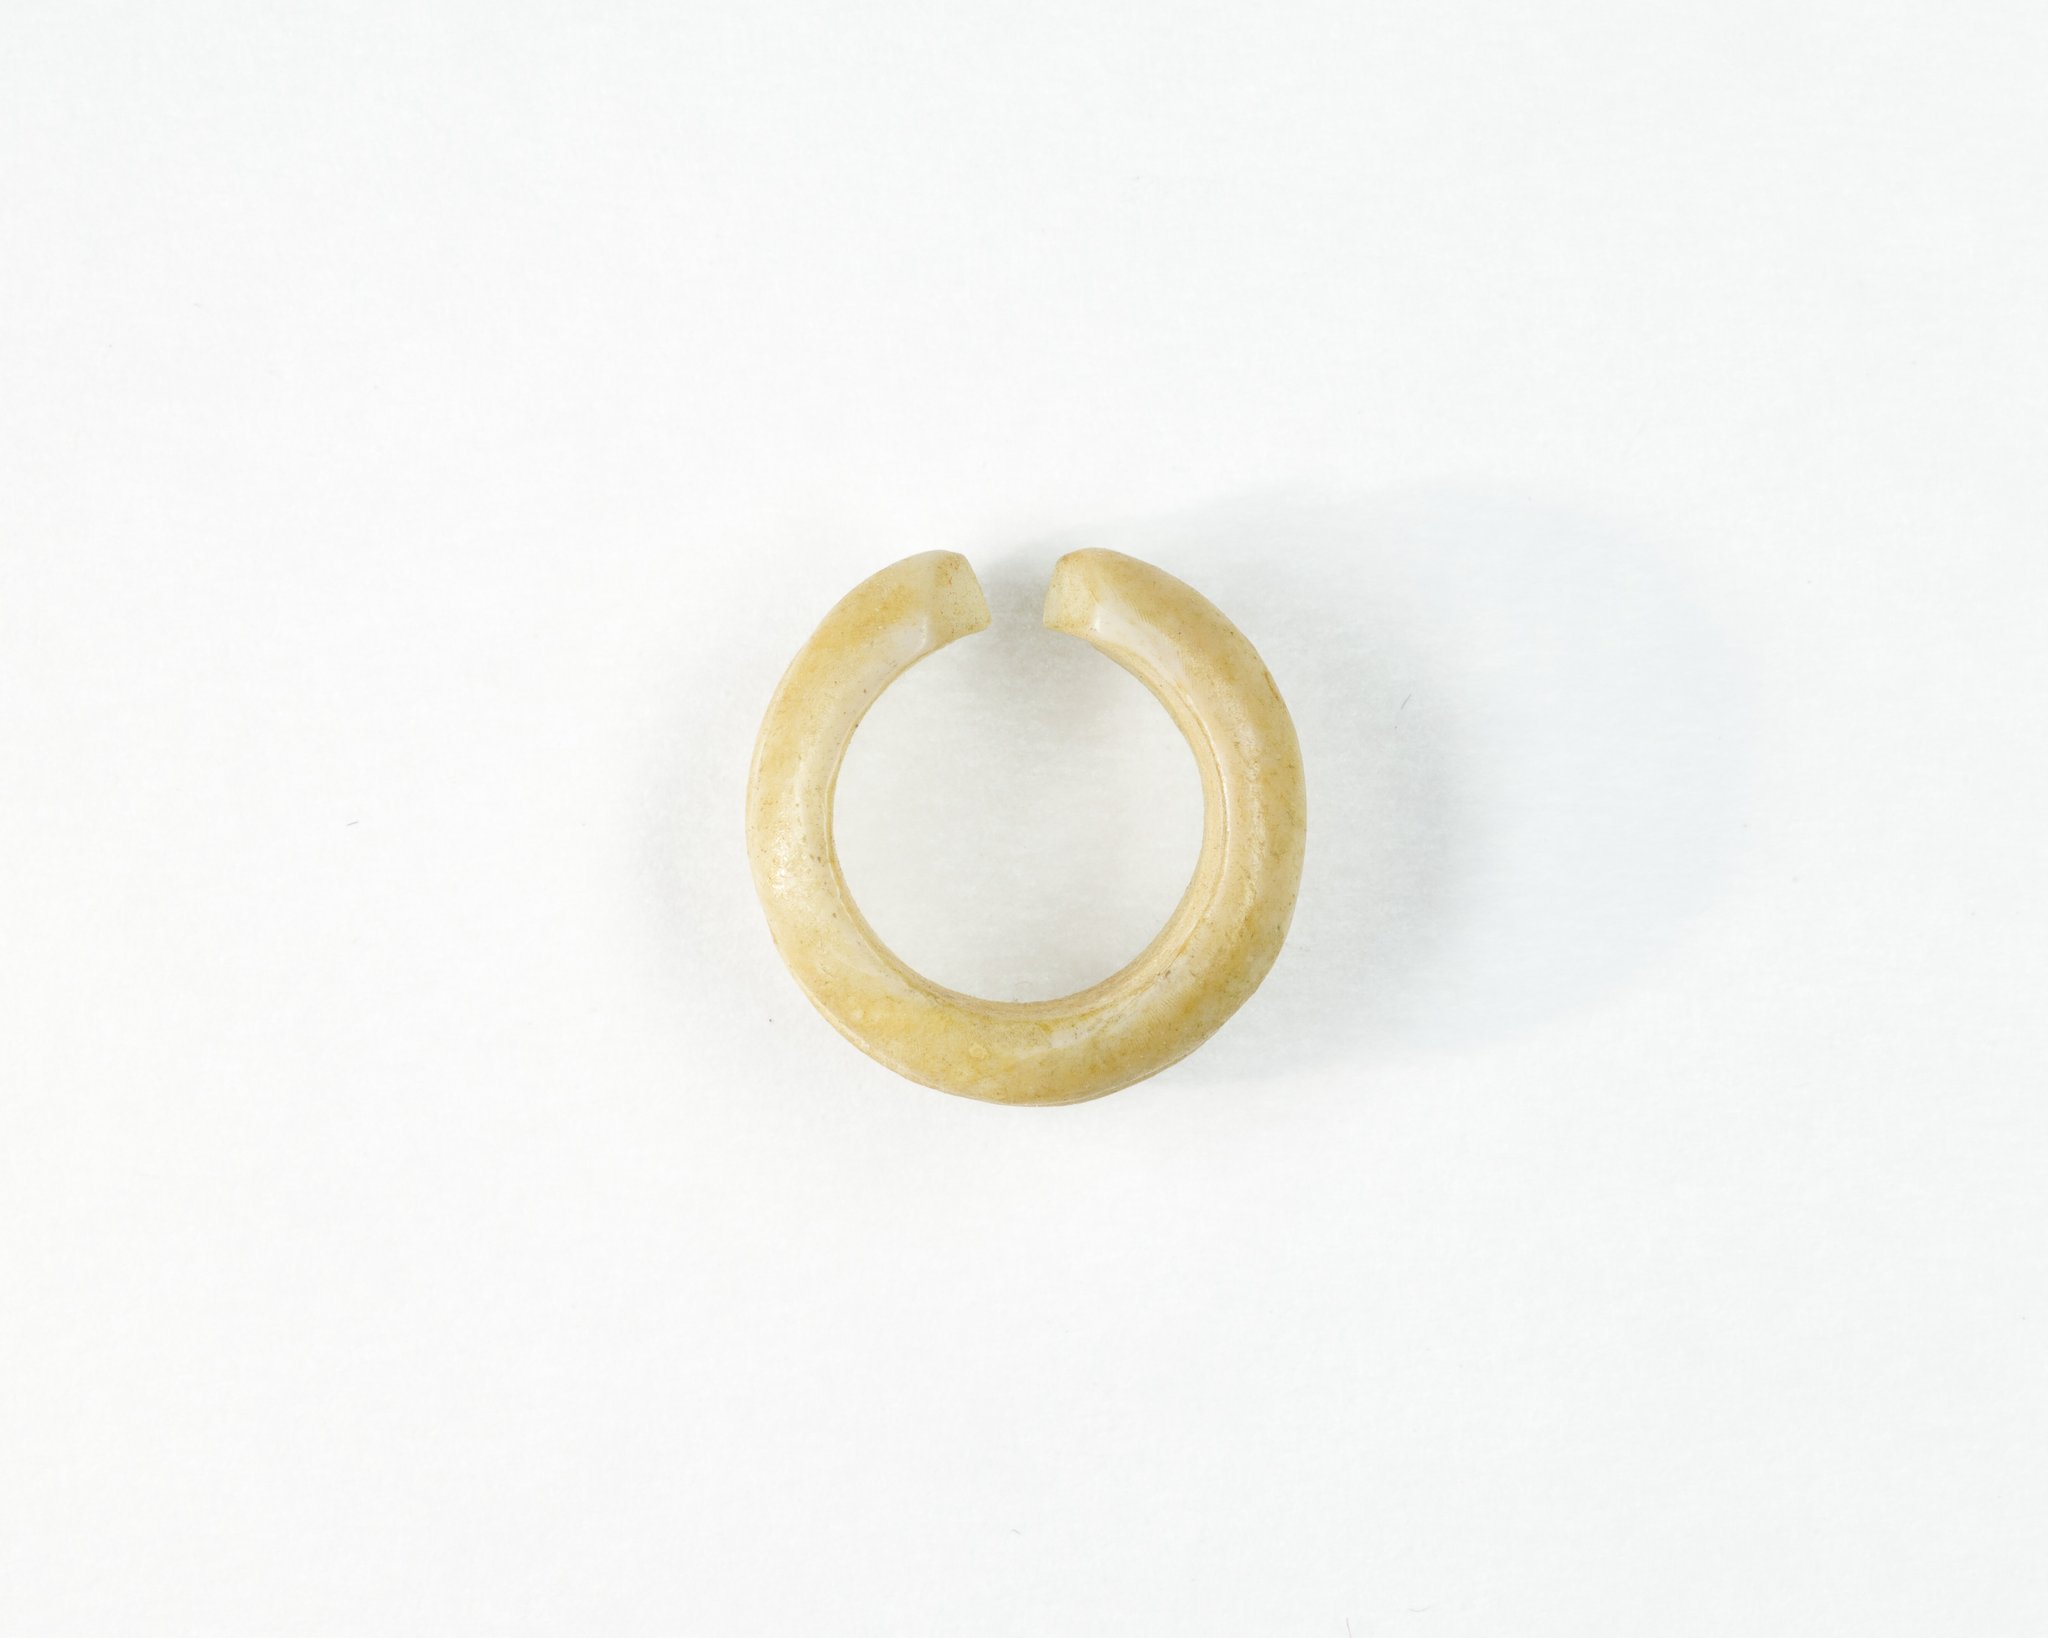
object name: earring, penannular, circular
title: Penannular Earring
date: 1550-1295 BCE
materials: shell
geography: northern upper egypt